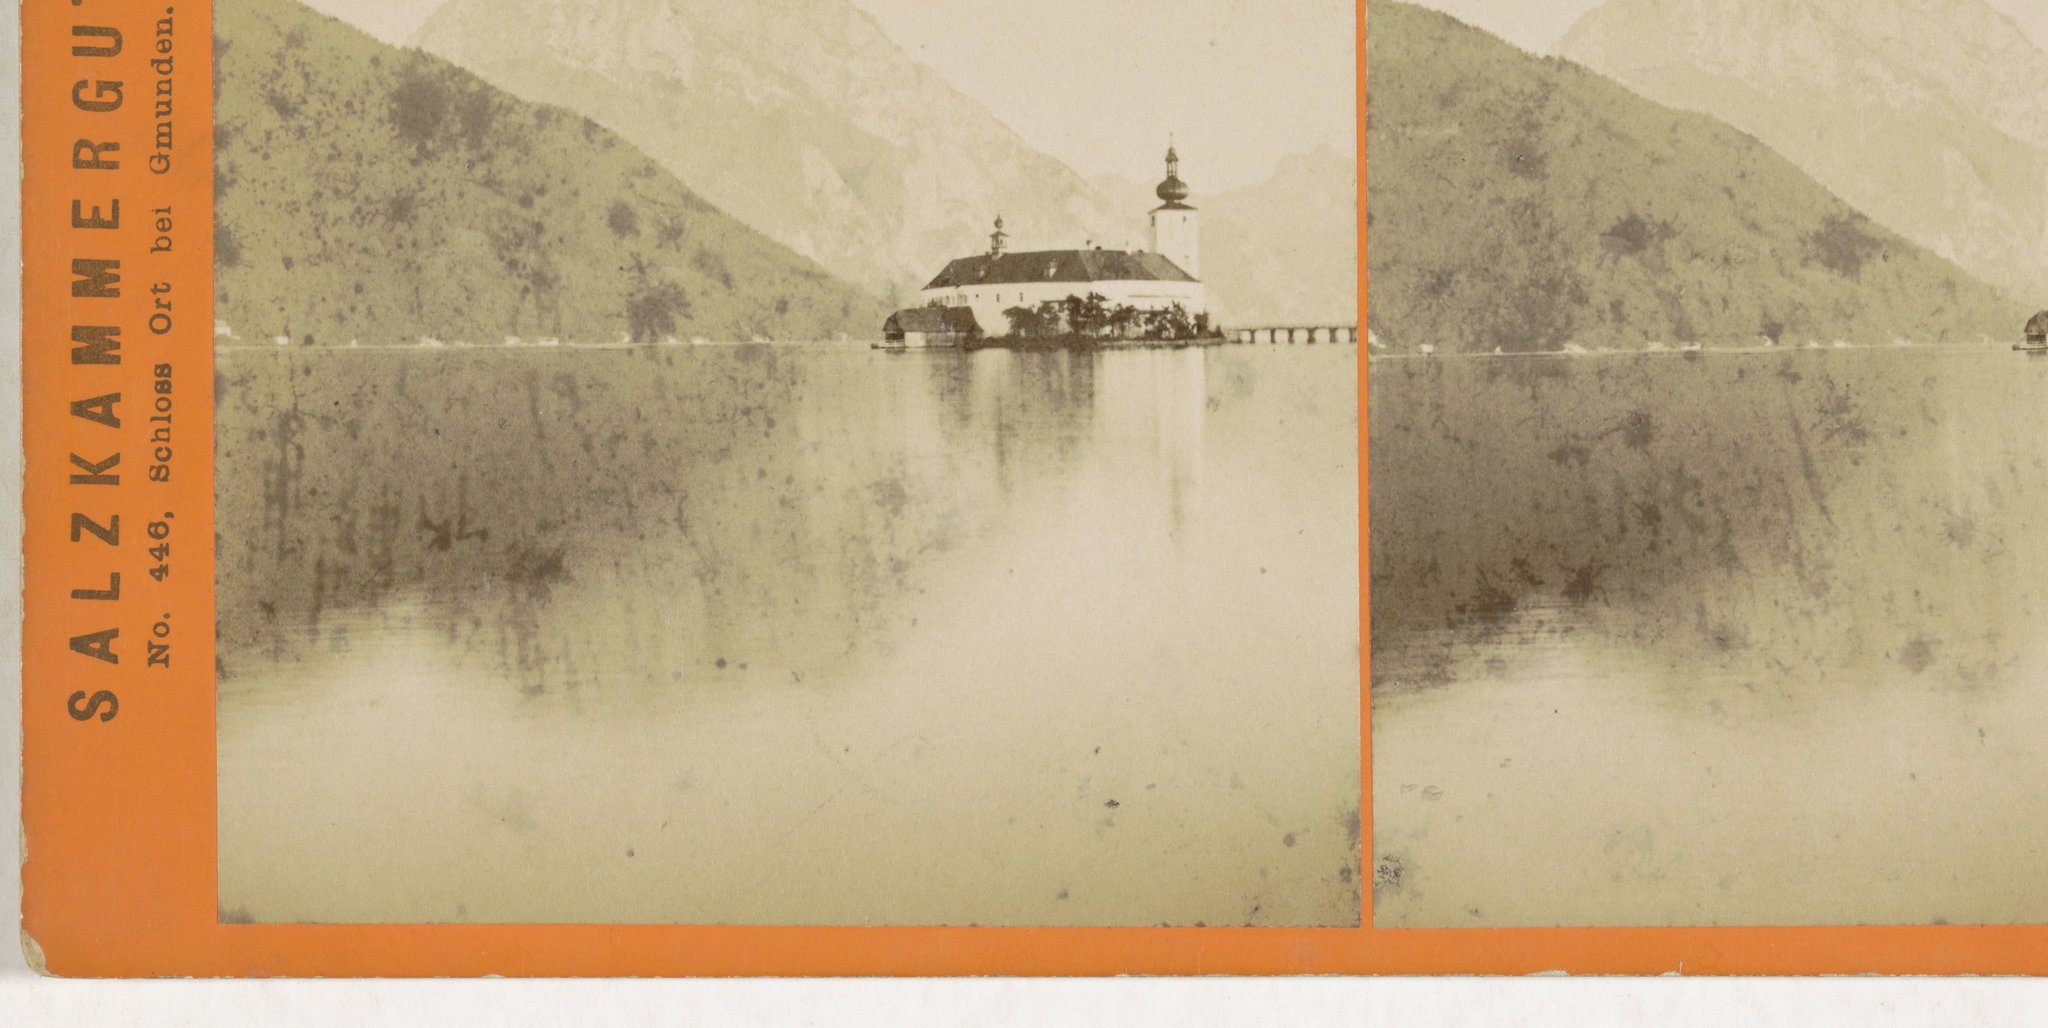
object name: stereograph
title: Slot Ort aan de Traunsee bij Gmunden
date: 1862-1880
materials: cardboard, paper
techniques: albumen print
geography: traunsee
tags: castle, lake, landscape with tower or castle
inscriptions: number: ‘No. 446’